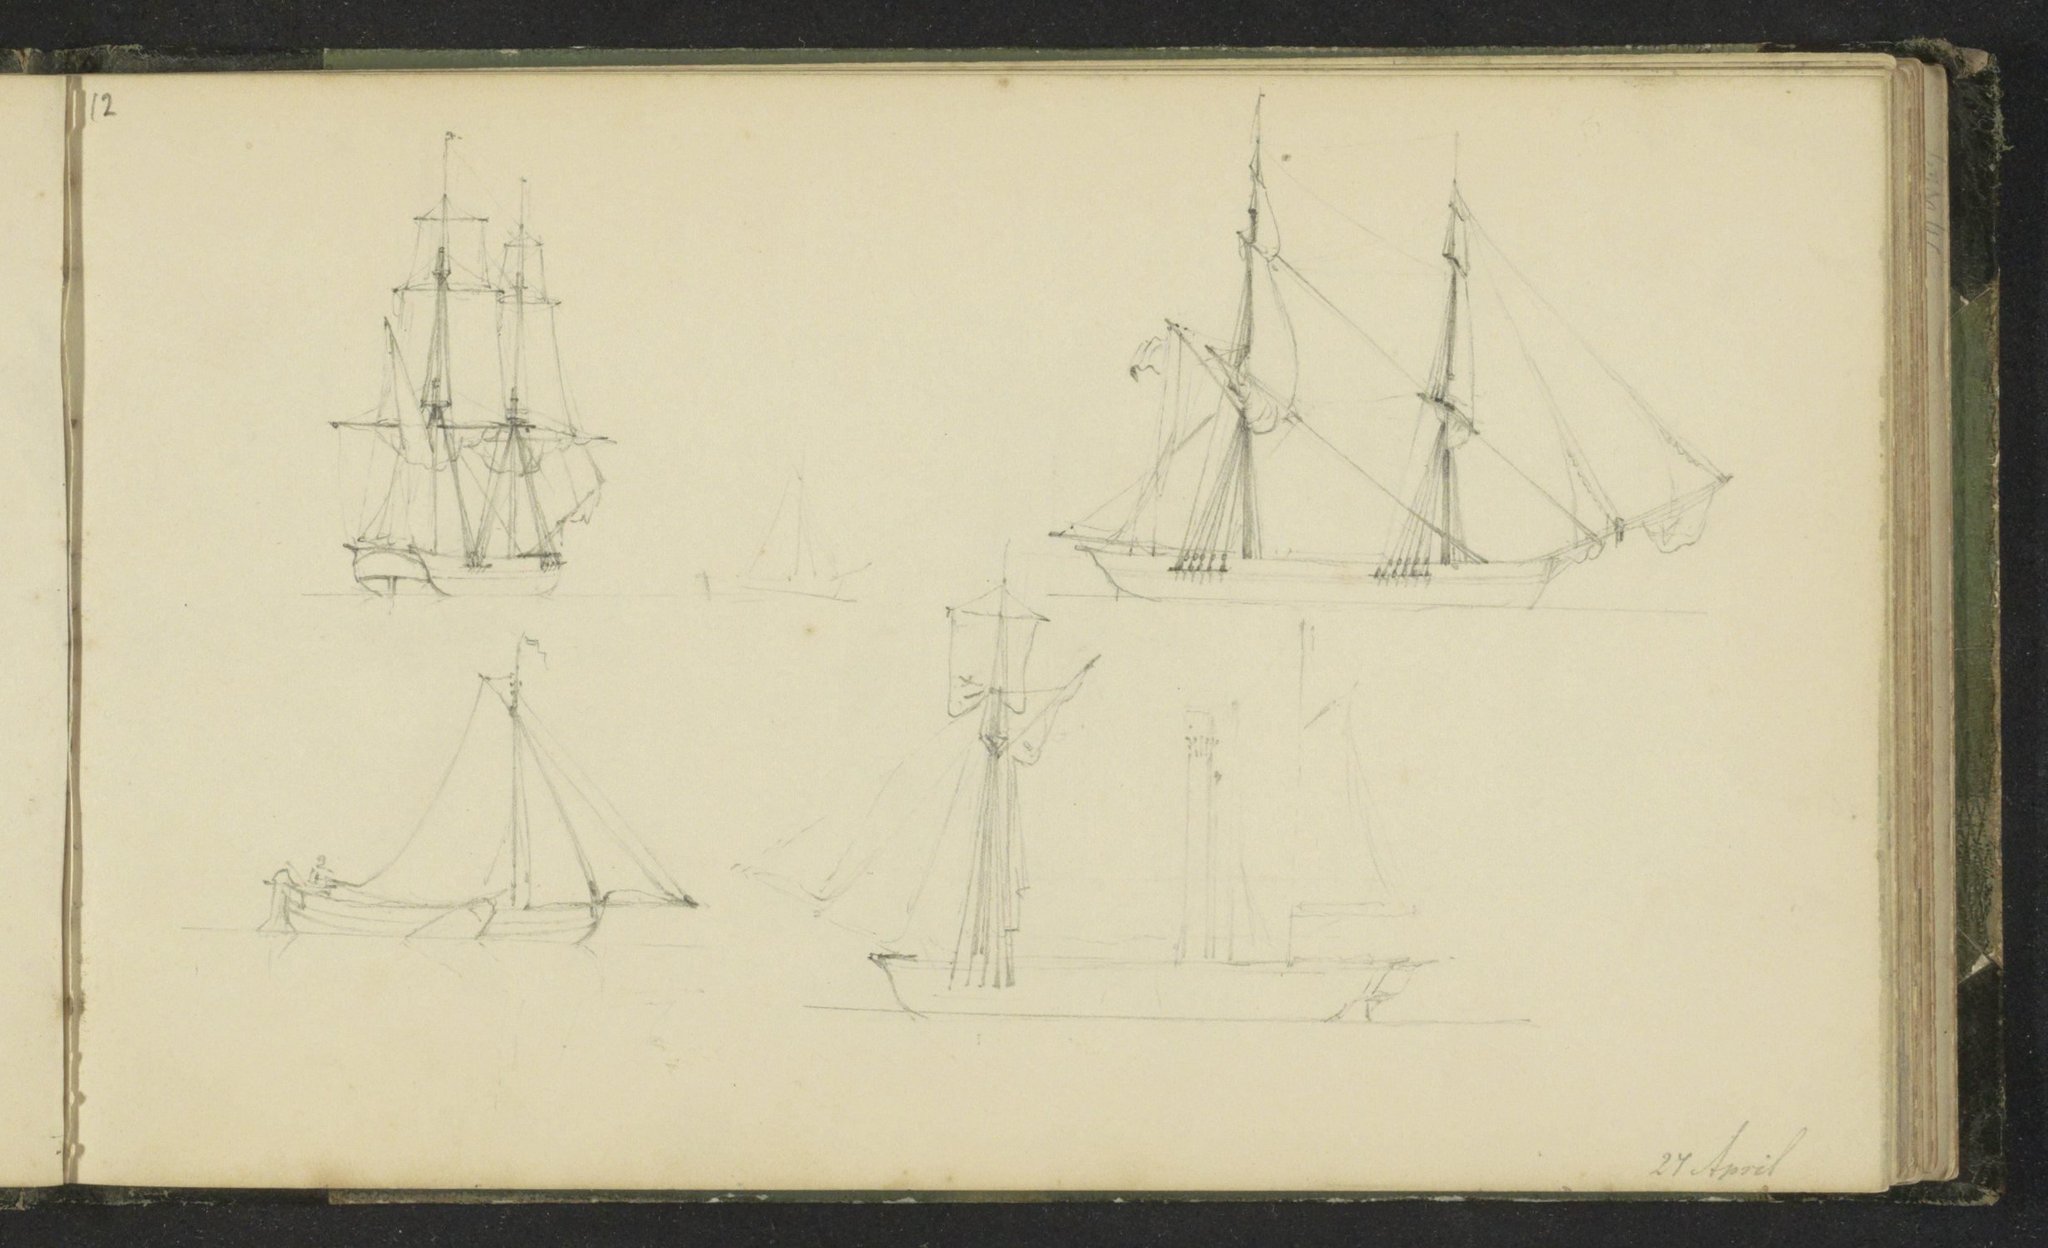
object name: sketchbook leaf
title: Studieblad met zeilschepen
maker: hendrik abraham klinkhamer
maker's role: draughtsman, painter, print maker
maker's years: 1810-1872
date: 1804-1843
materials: paper, pencil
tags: sailing-ship, sailing-boat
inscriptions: date: ‘27 April’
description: Blad 12 recto uit een schetsboek met 40 bladen.